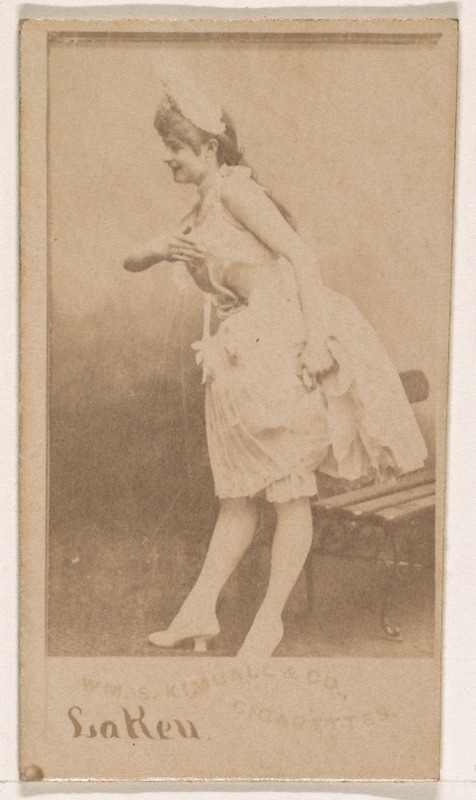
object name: photograph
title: Miss Laken, from the Actresses series (N203) issued by Wm. S. Kimball & Co.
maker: william s. kimball & company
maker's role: publisher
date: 1889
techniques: color lithograph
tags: portraits,women,actresses